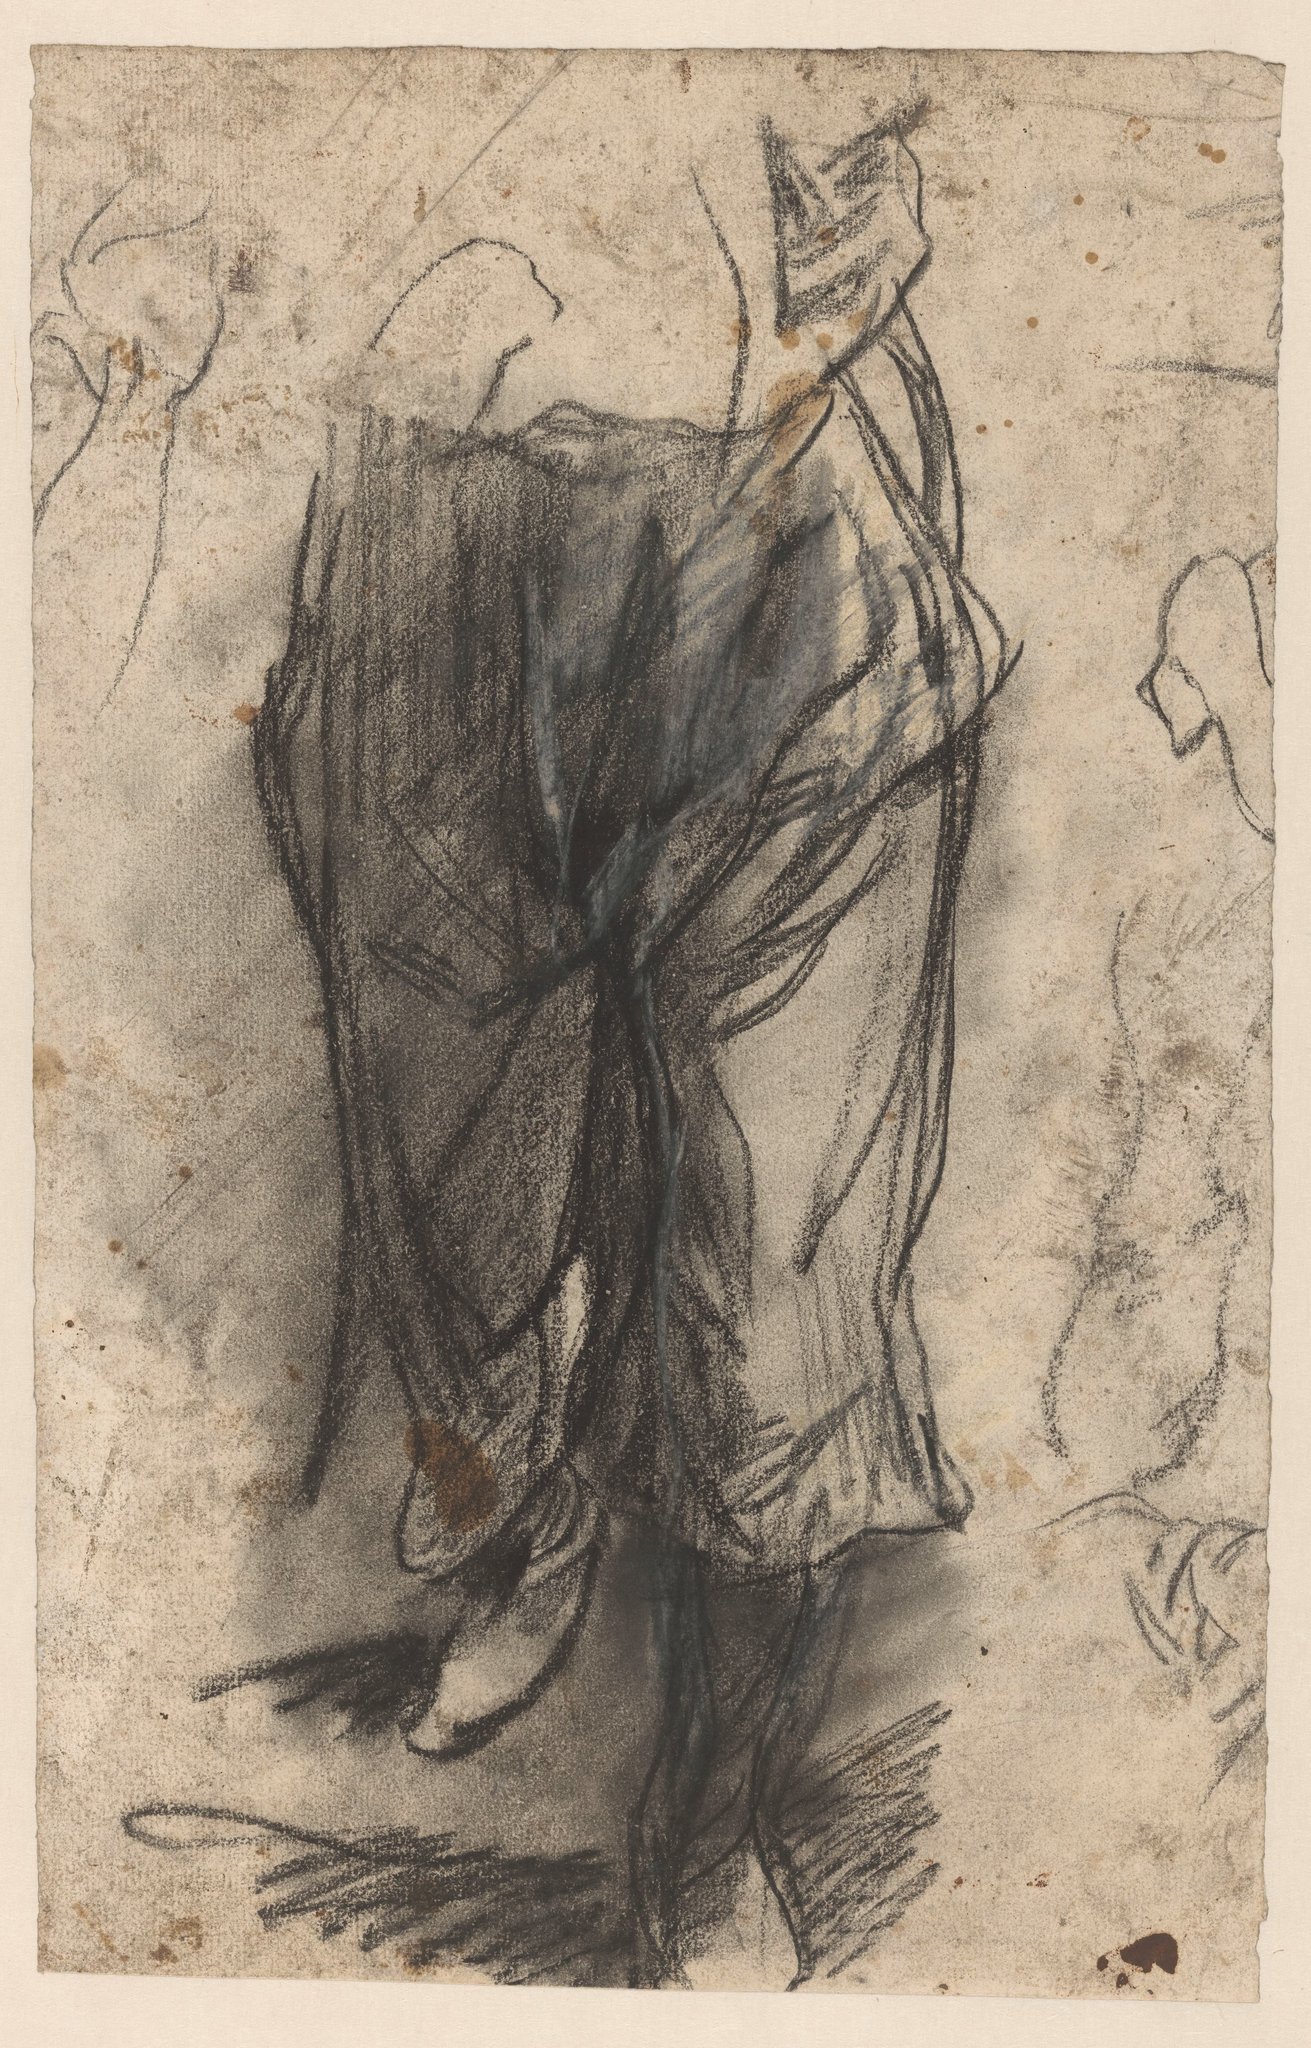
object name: drawing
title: Benen van een staande figuur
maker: jac van looij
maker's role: draughtsman, painter, print maker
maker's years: 1855-1930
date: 1865-1930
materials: chalk, paper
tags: legs